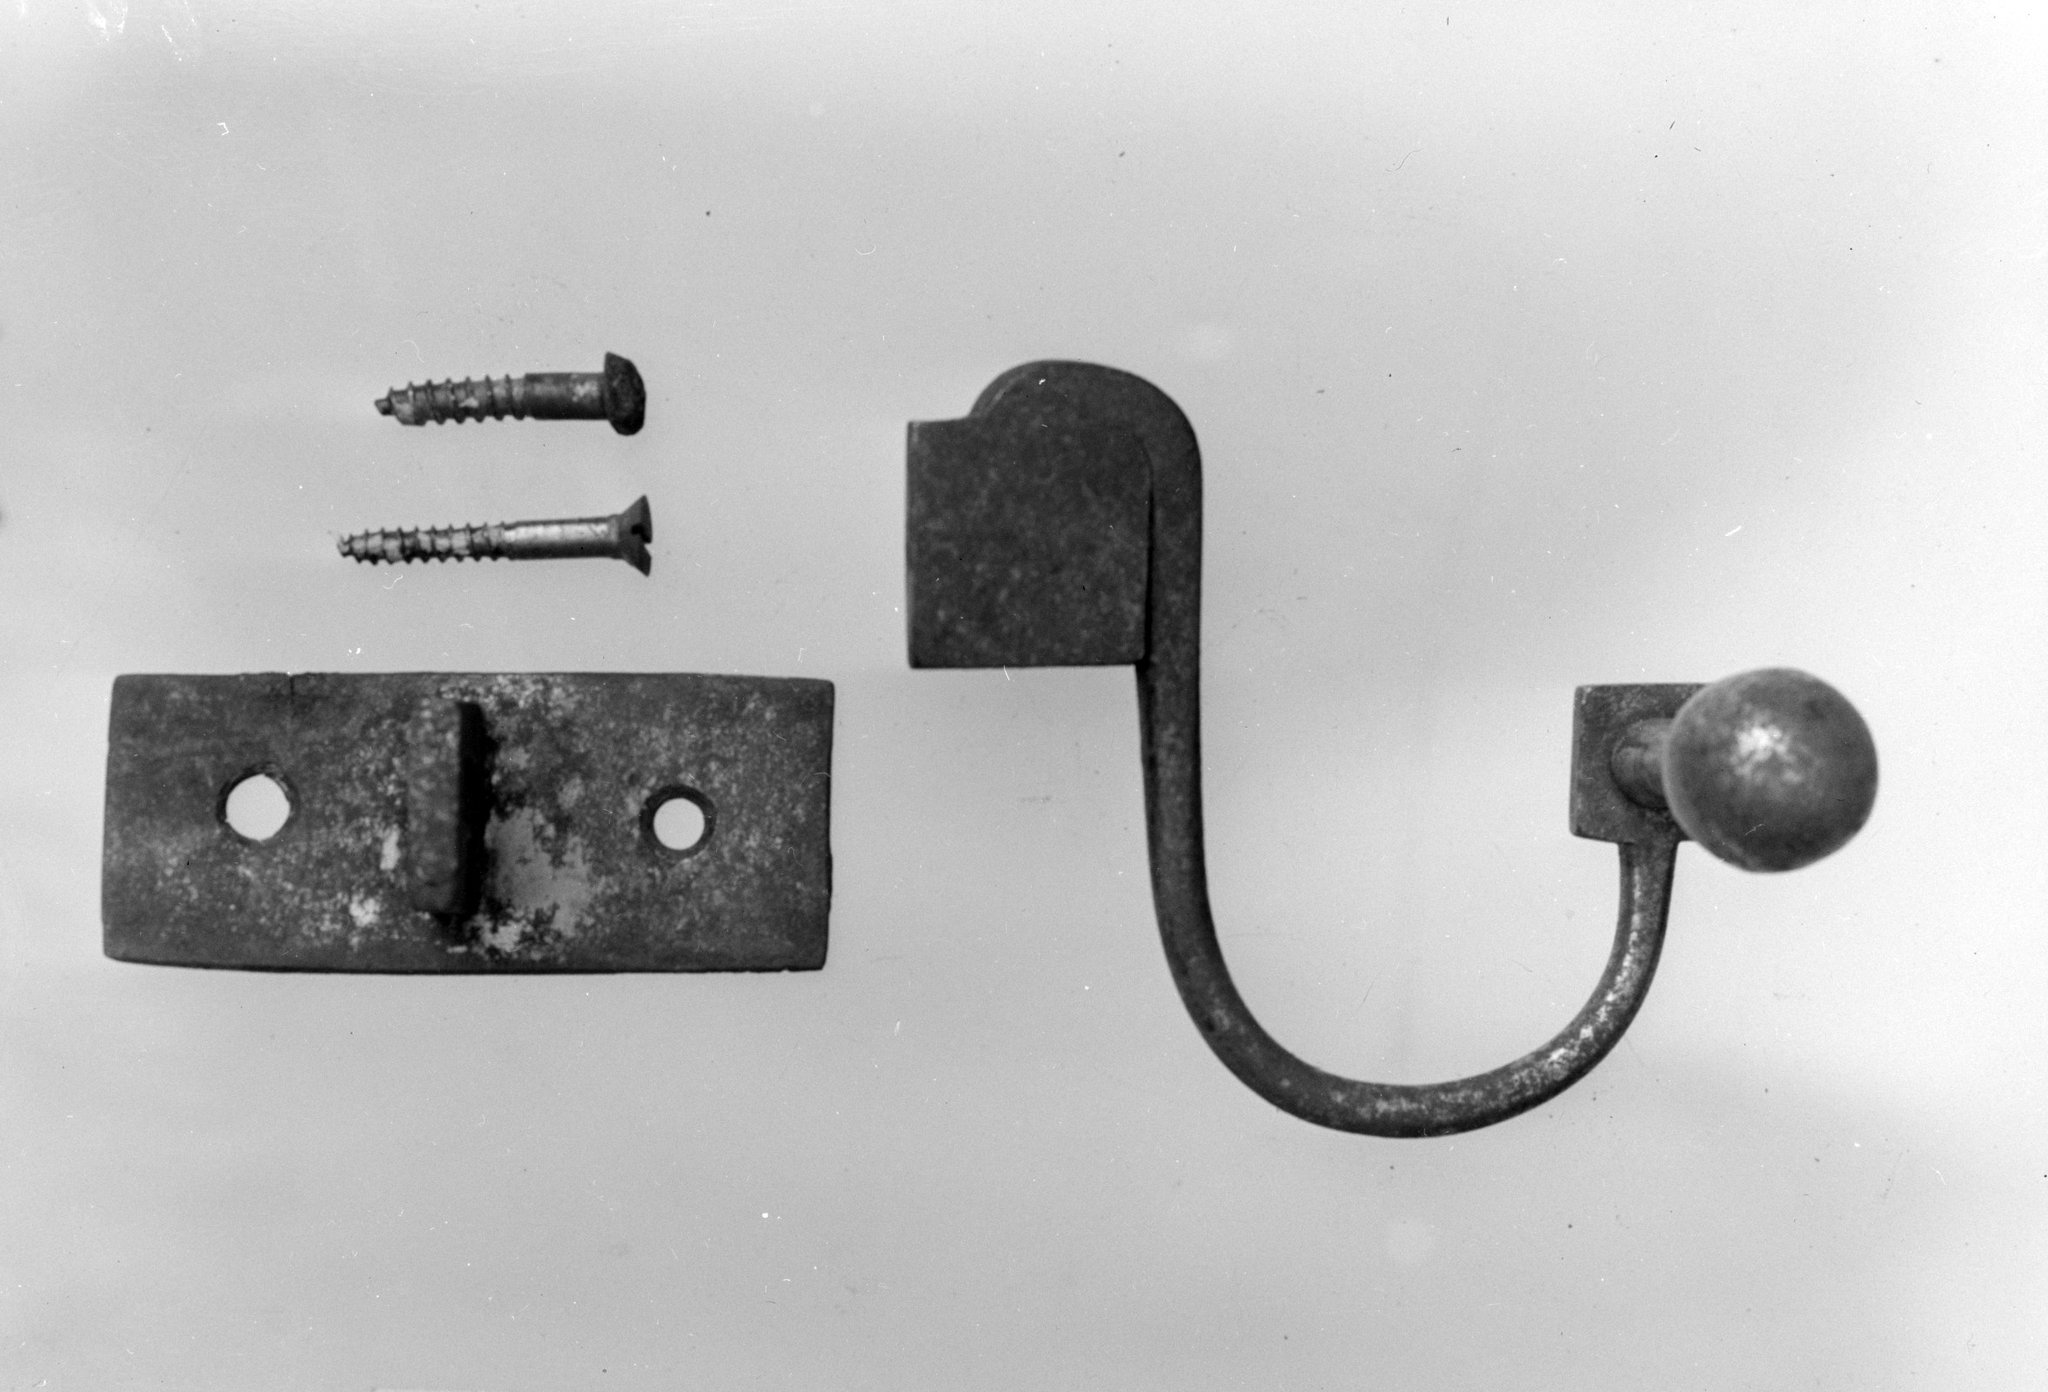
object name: jamb hook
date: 1700-1800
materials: iron